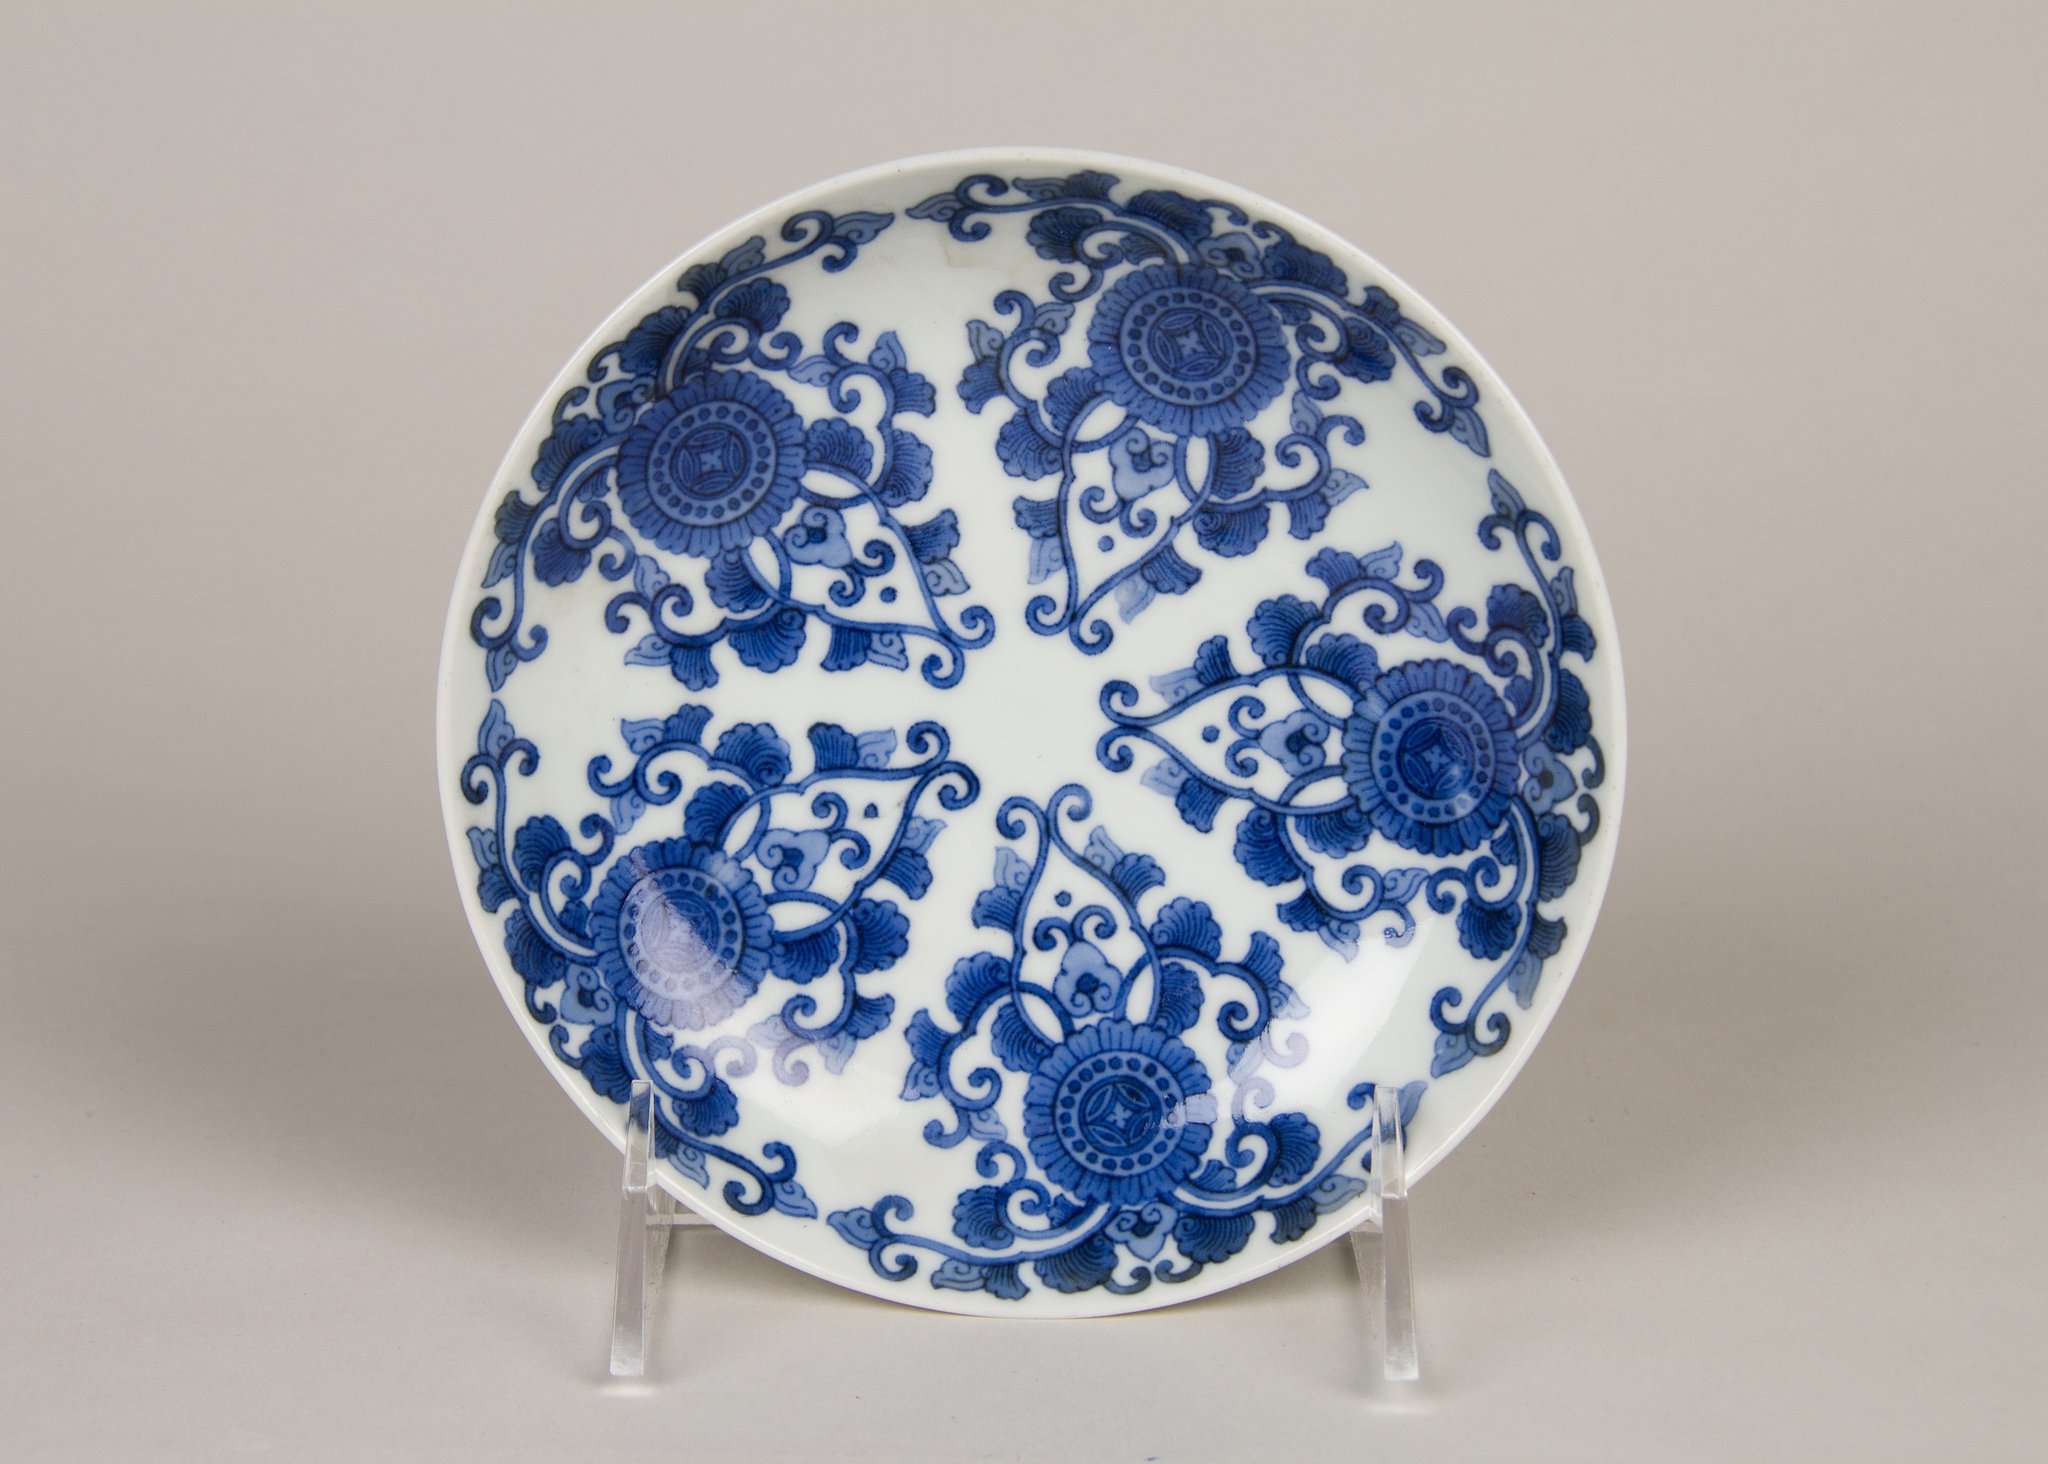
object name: dish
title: Dish with Stylized Chrysanthemum Scrolls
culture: japanese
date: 1701-1750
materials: porcelain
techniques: underglaze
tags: flowers